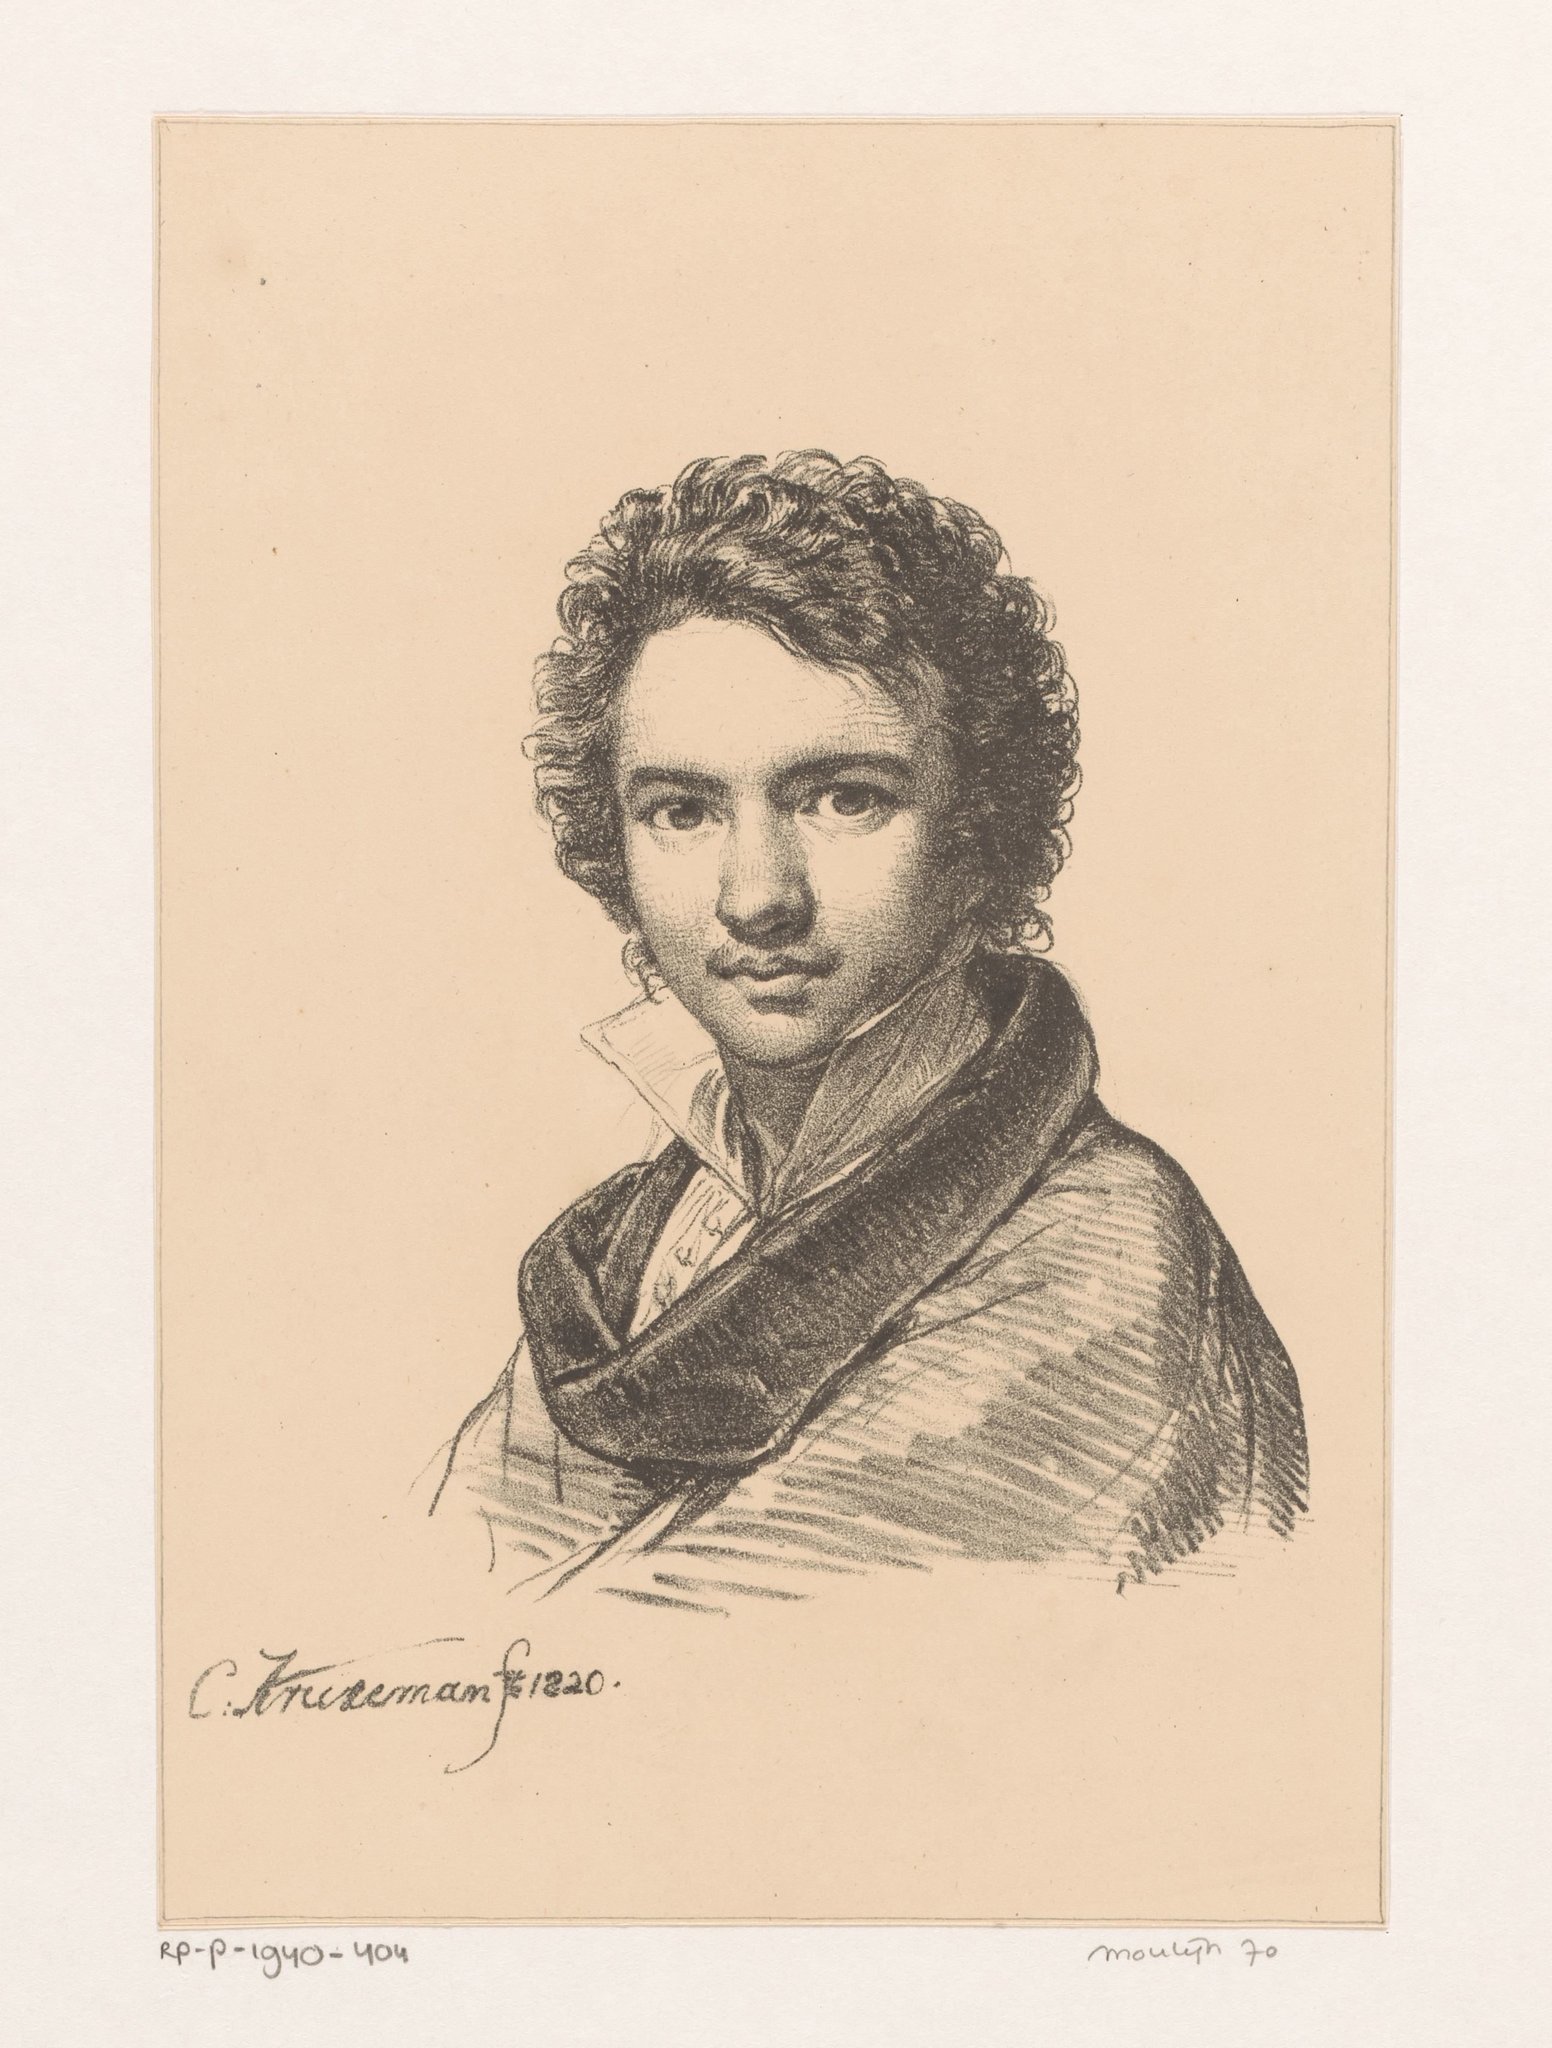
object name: print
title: Zelfportret van Cornelis Kruseman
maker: cornelis kruseman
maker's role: draughtsman, painter, print maker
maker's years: 1797-1857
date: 1820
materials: paper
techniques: lithograph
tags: amsterdam, painter, print maker, draughtsman, cornelis kruseman, portrait, self-portrait of artist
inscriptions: collector's mark: Lugt 2228, collector's mark: Lugt 2760